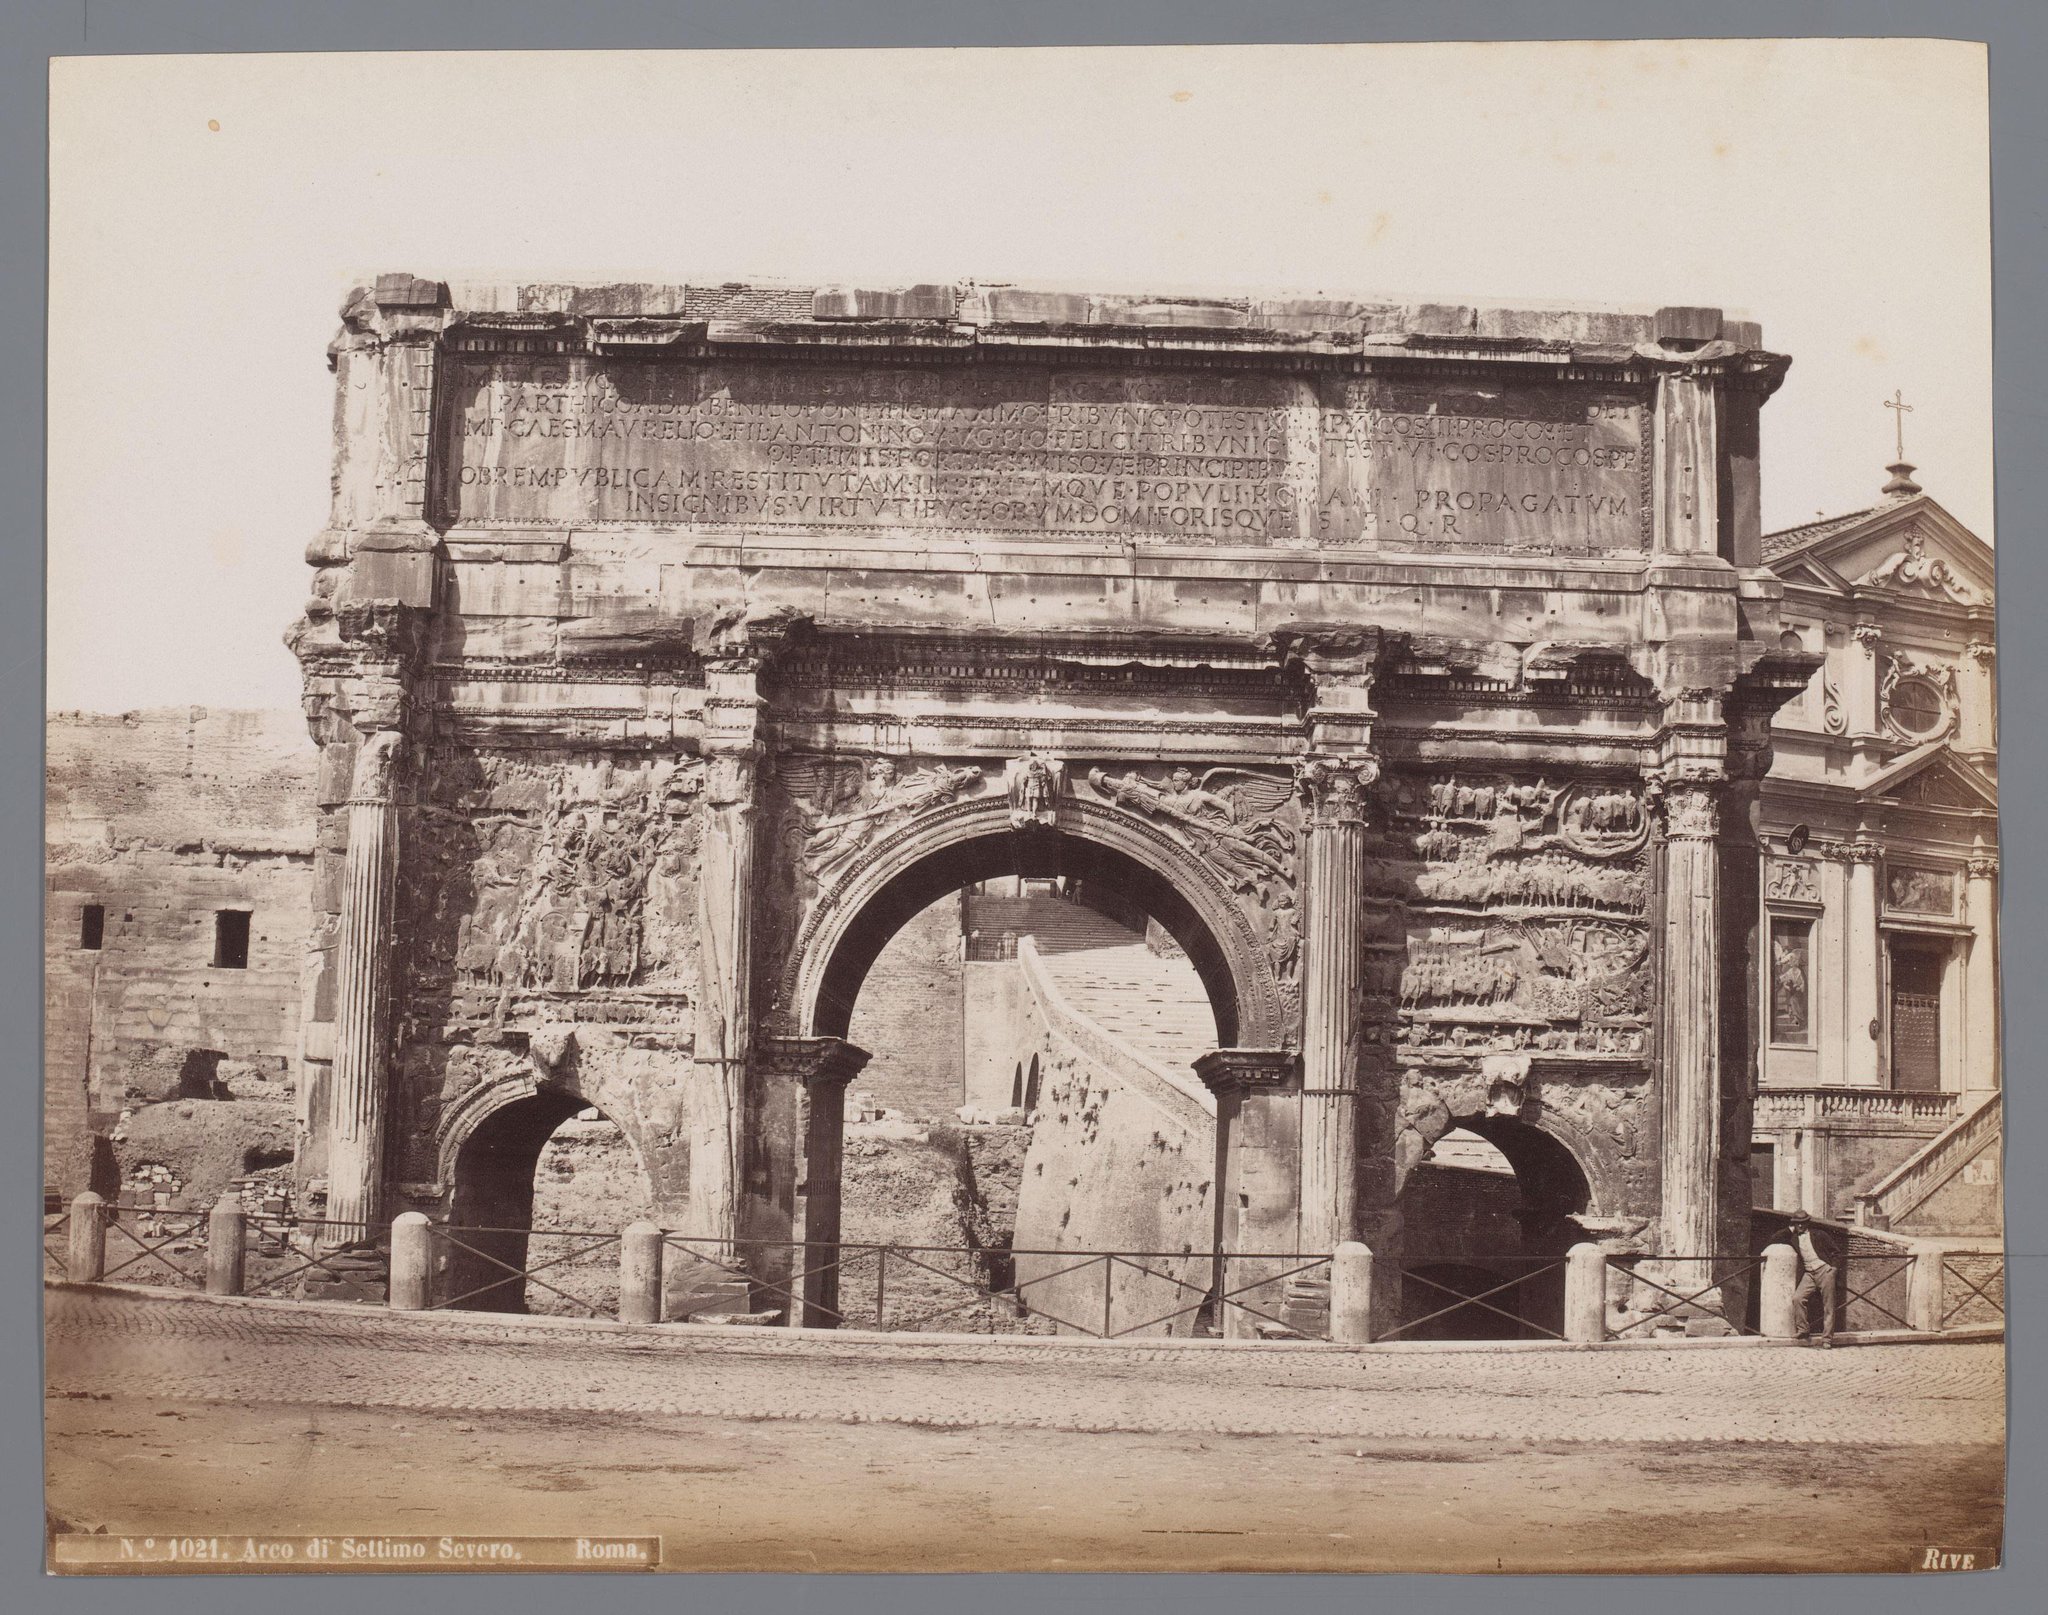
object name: photograph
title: Arco di Settimo Severo. Roma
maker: roberto rive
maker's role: fotograaf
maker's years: 1825-1868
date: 1860-1889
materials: paper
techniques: albumen print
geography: rome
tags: triumphal arch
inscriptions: number: ‘No. 1021’